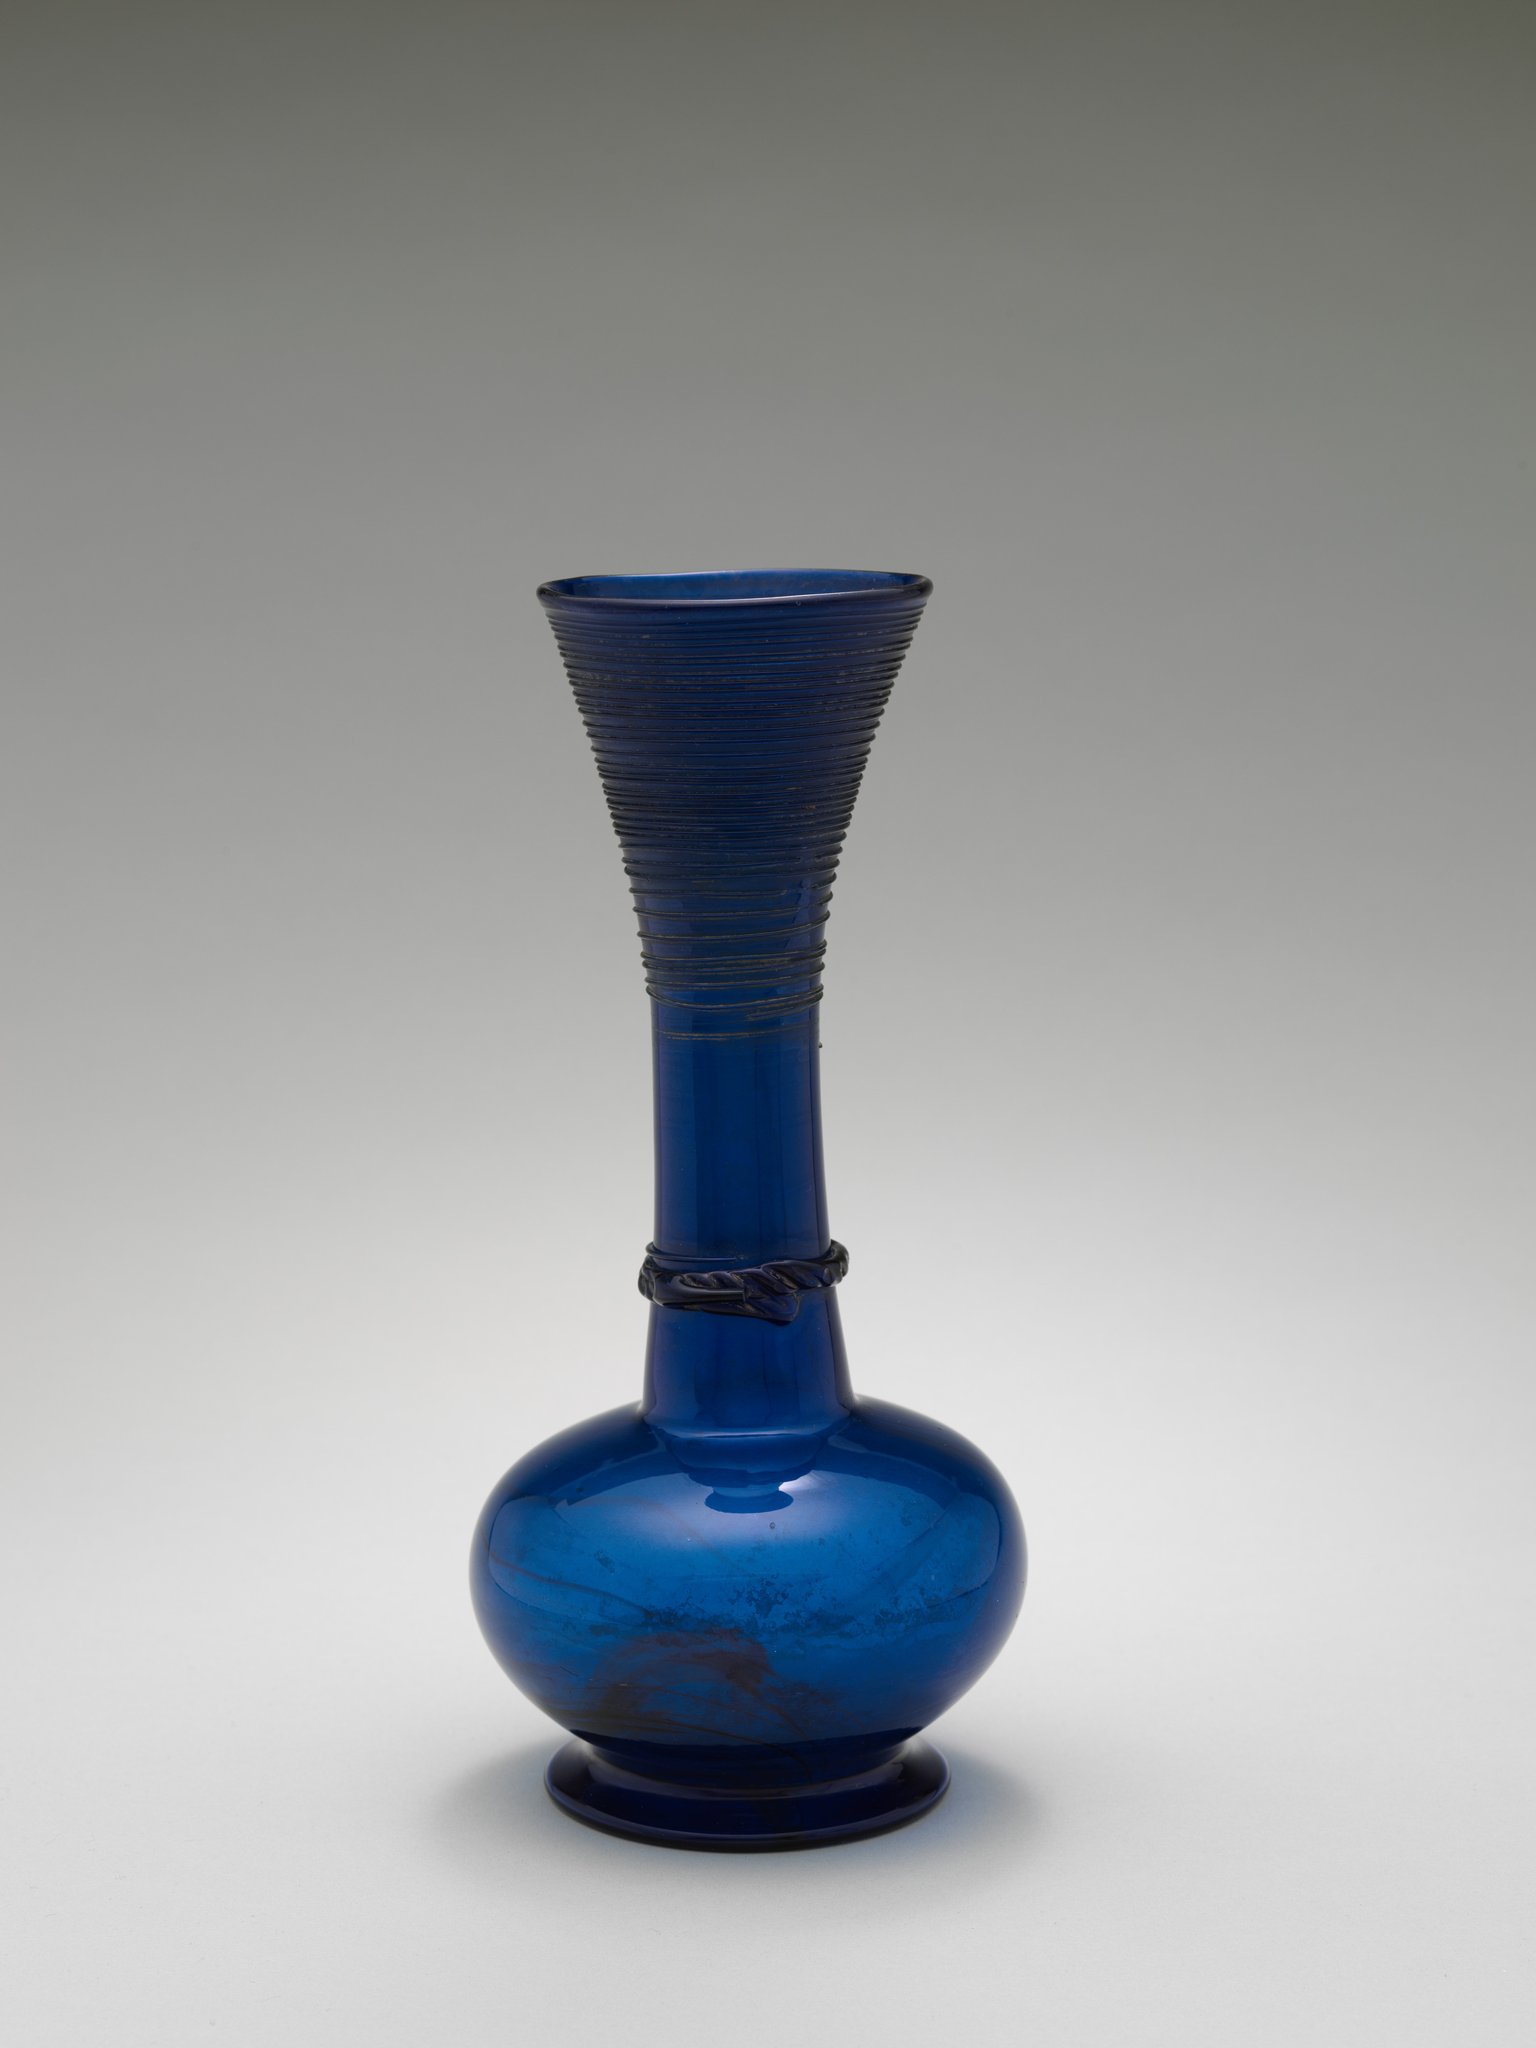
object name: bottle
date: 1701-1900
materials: glass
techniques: glassblowing, tooling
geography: iran